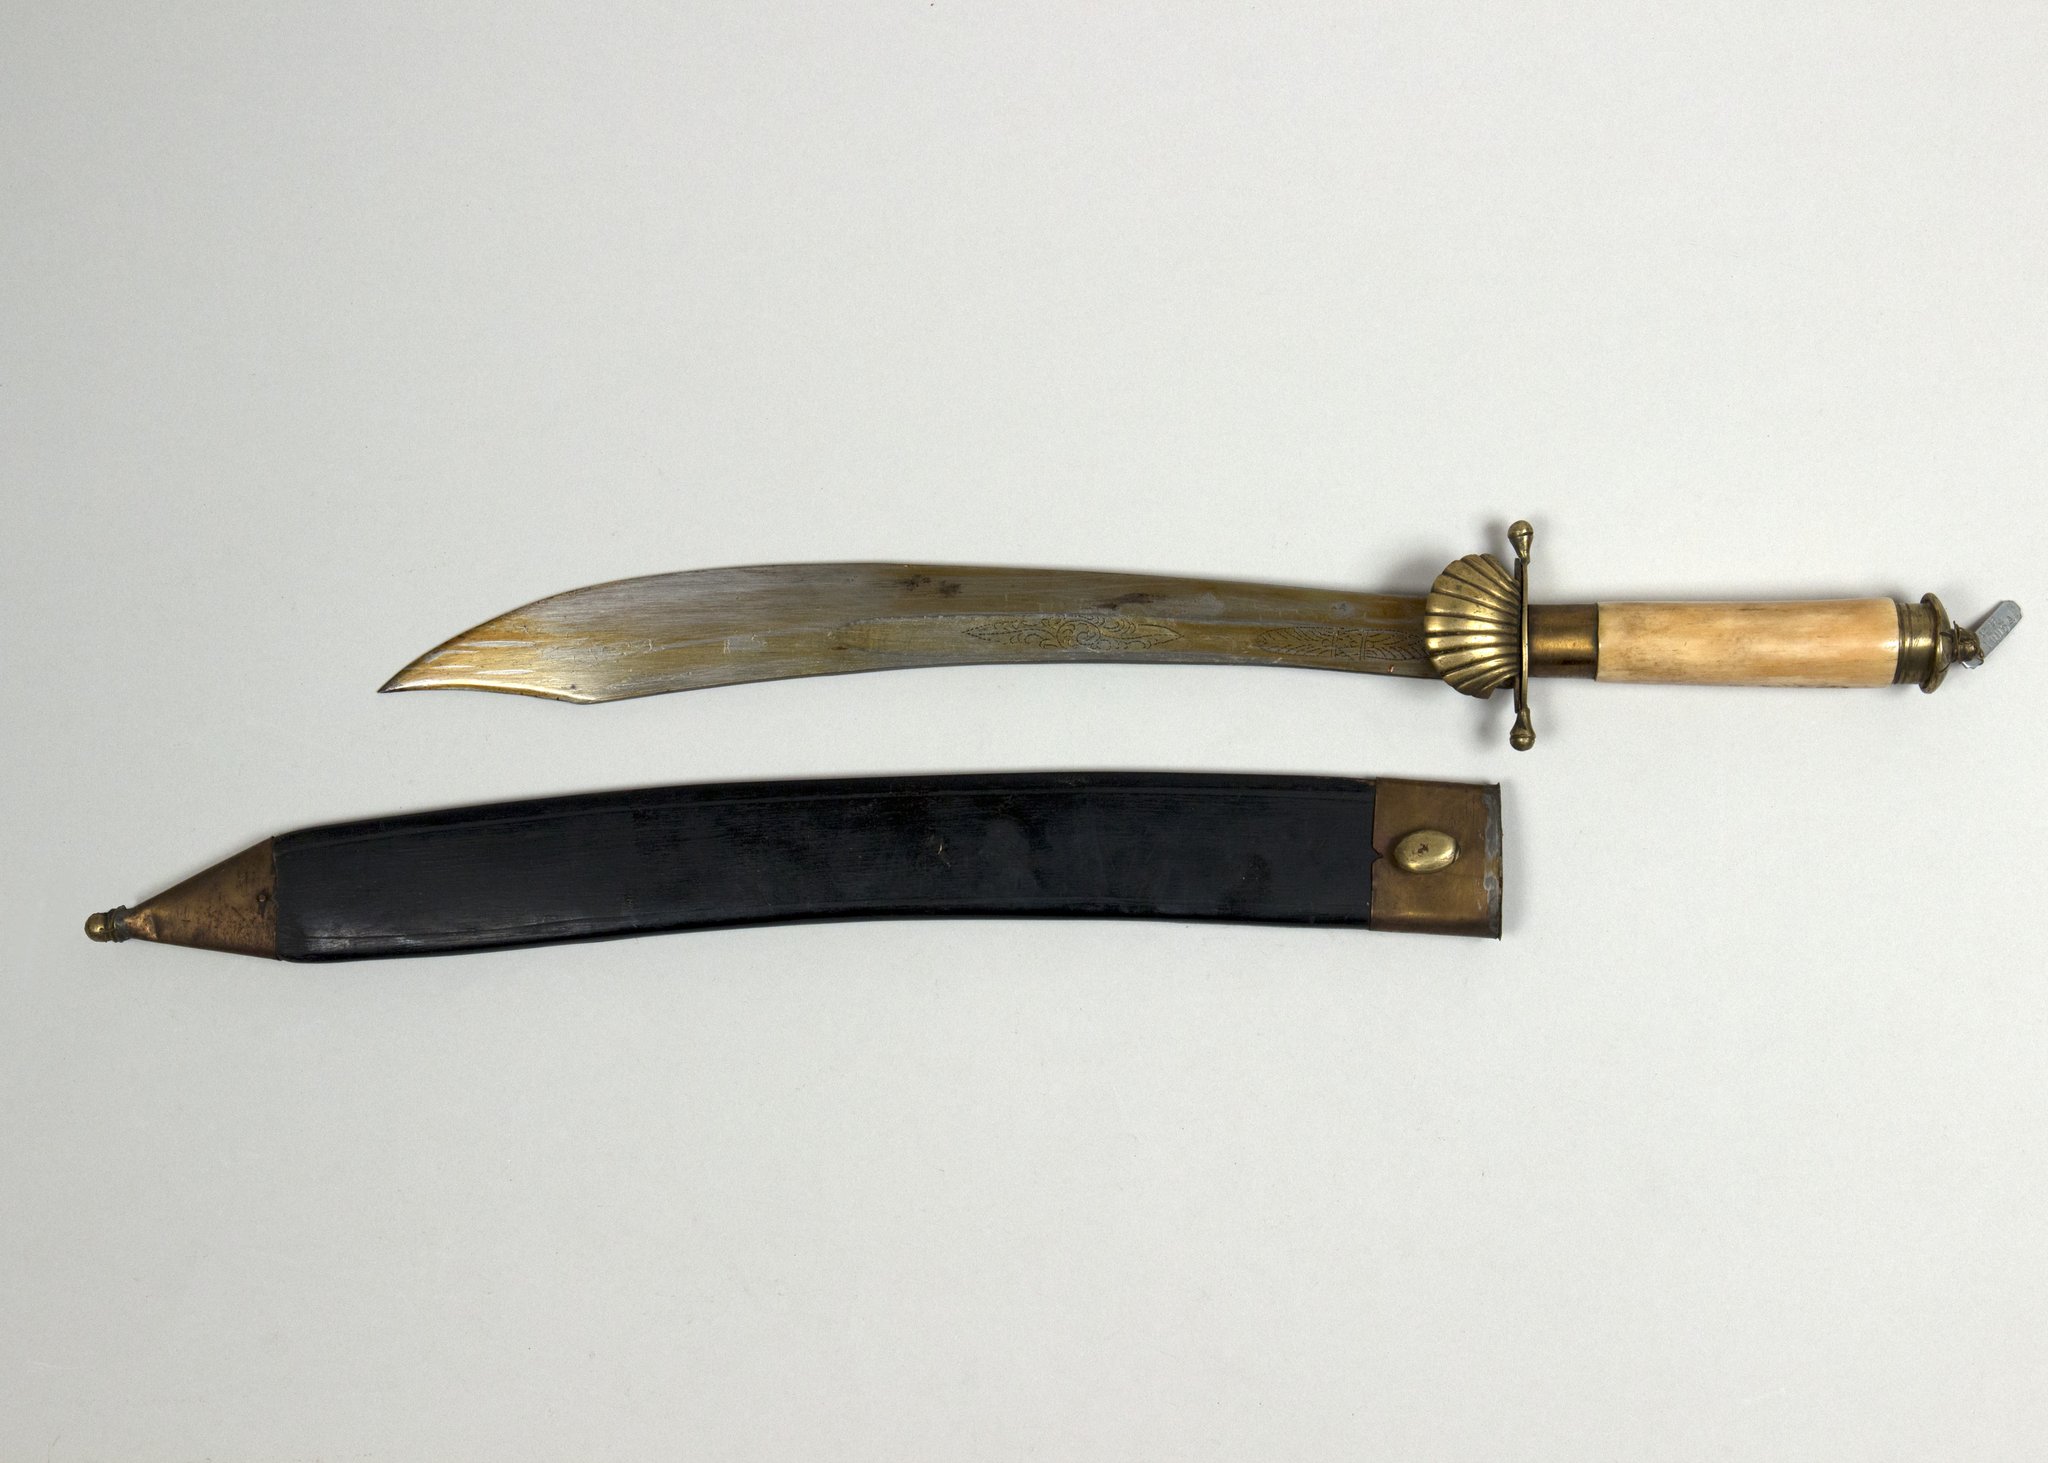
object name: hunting knife with sheath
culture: javanese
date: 1501-1900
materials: bone, steel, wood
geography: indonesia